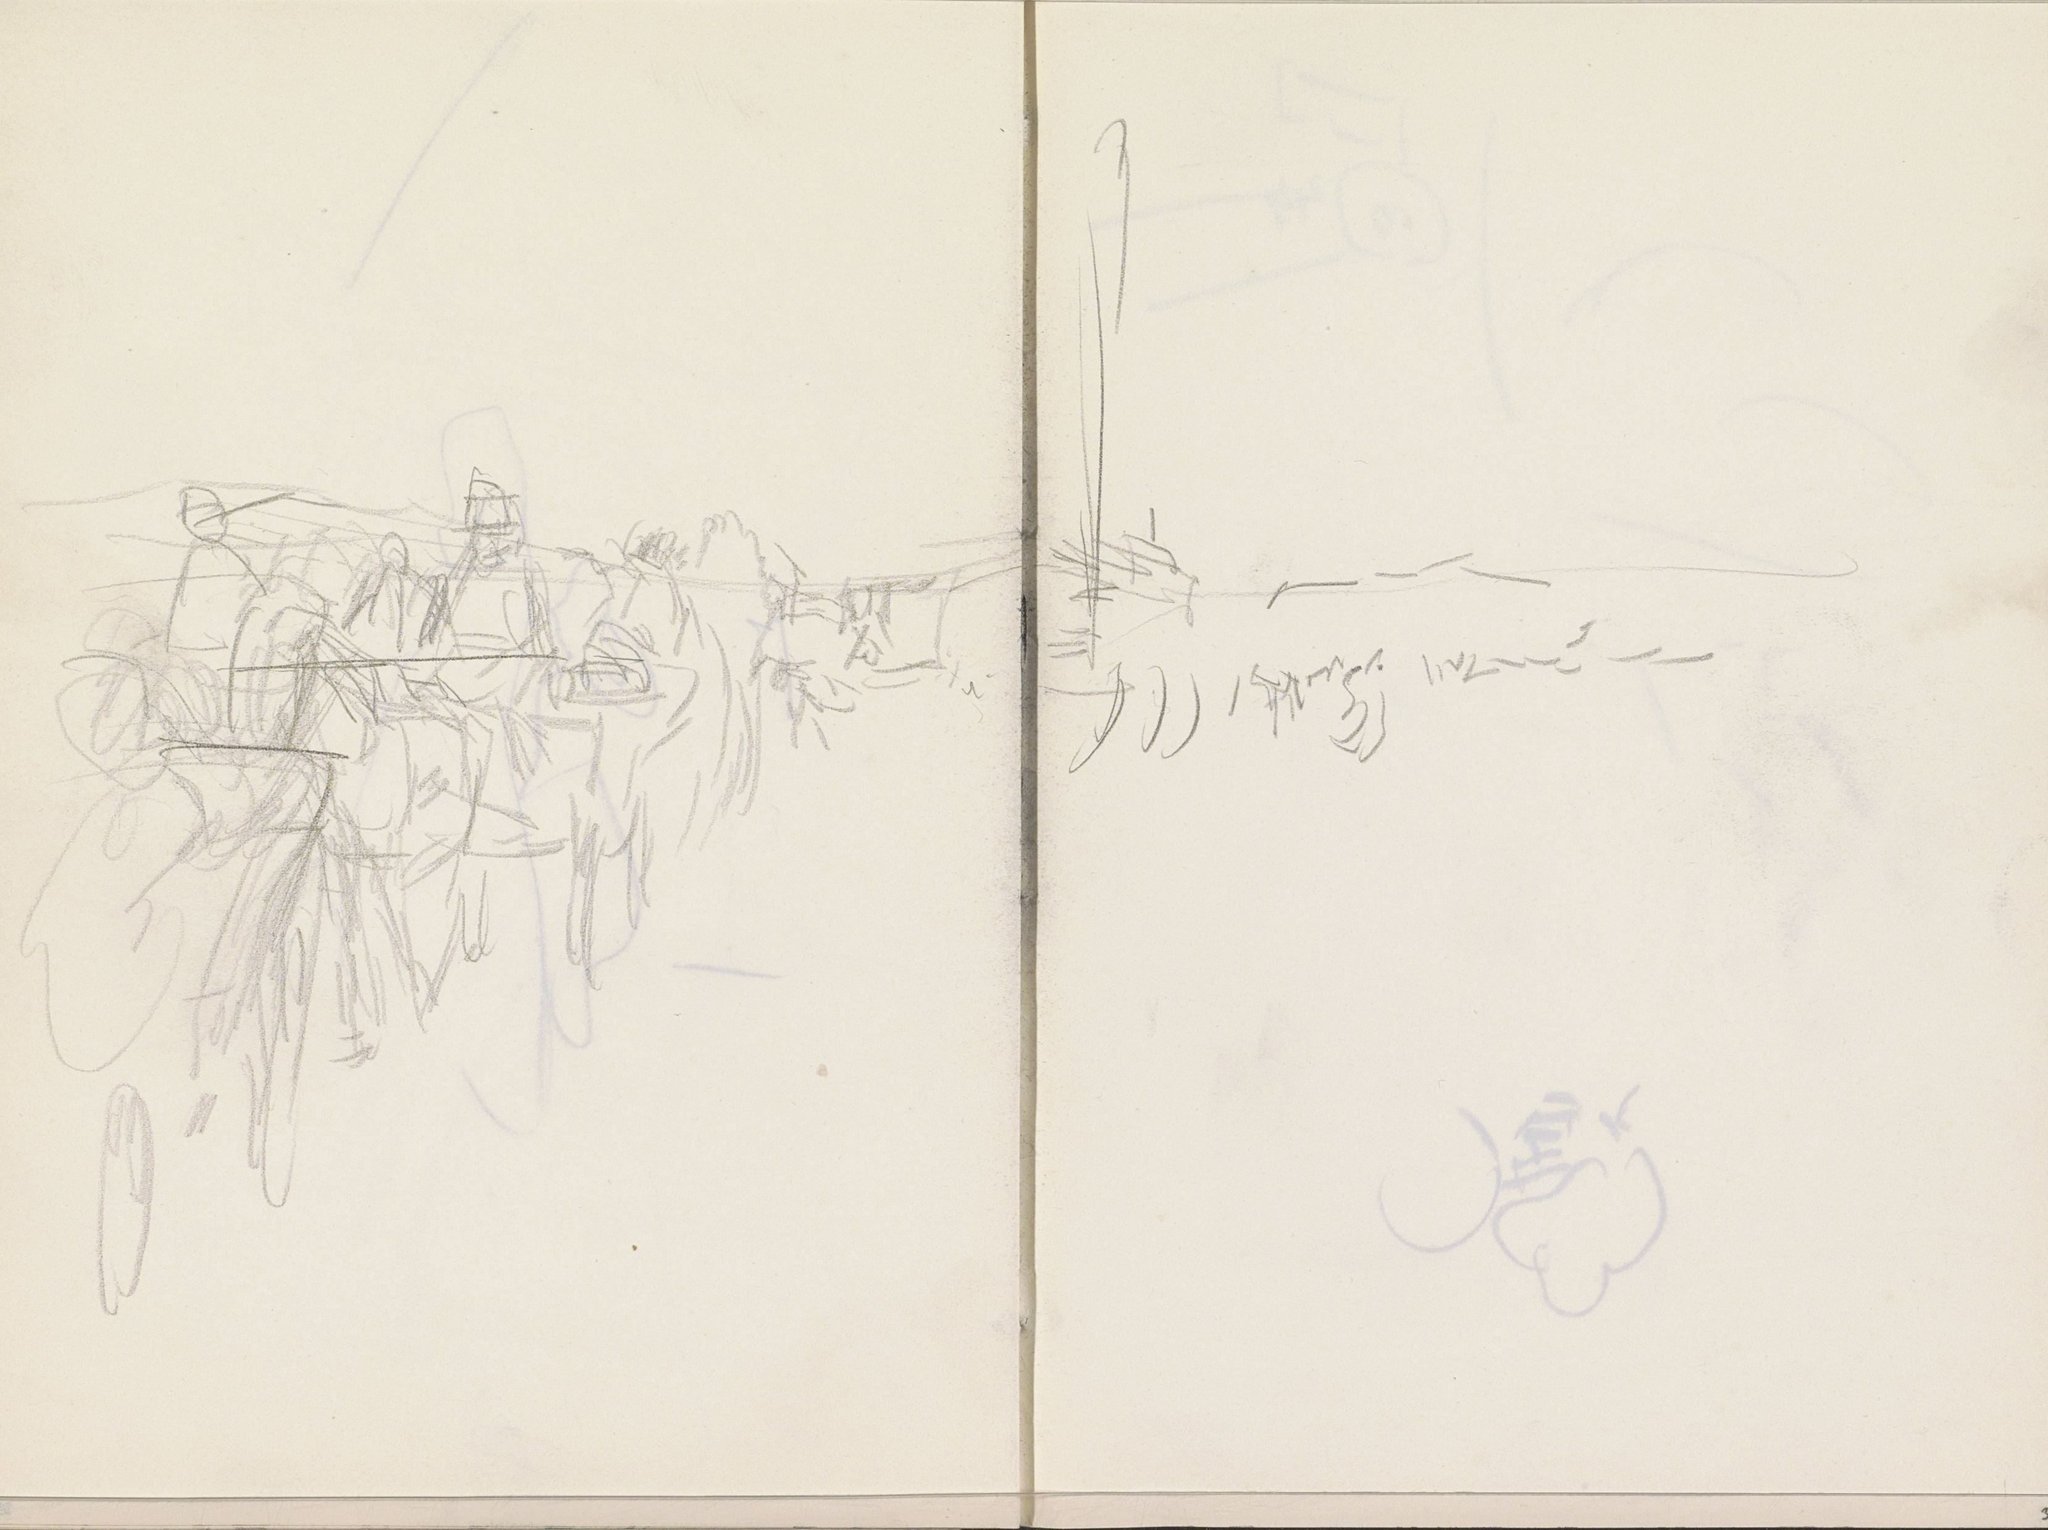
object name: sketchbook leaf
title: Paard-en-wagens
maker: isaac israels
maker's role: draughtsman, painter, print maker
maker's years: 1865-1934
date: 1875-1934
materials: paper, pencil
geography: paris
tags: four-wheeled, animal-drawn vehicle, e.g.: cab, carriage, coach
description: Blad 33 verso en blad 34 recto uit schetsboek L met 42 bladen.